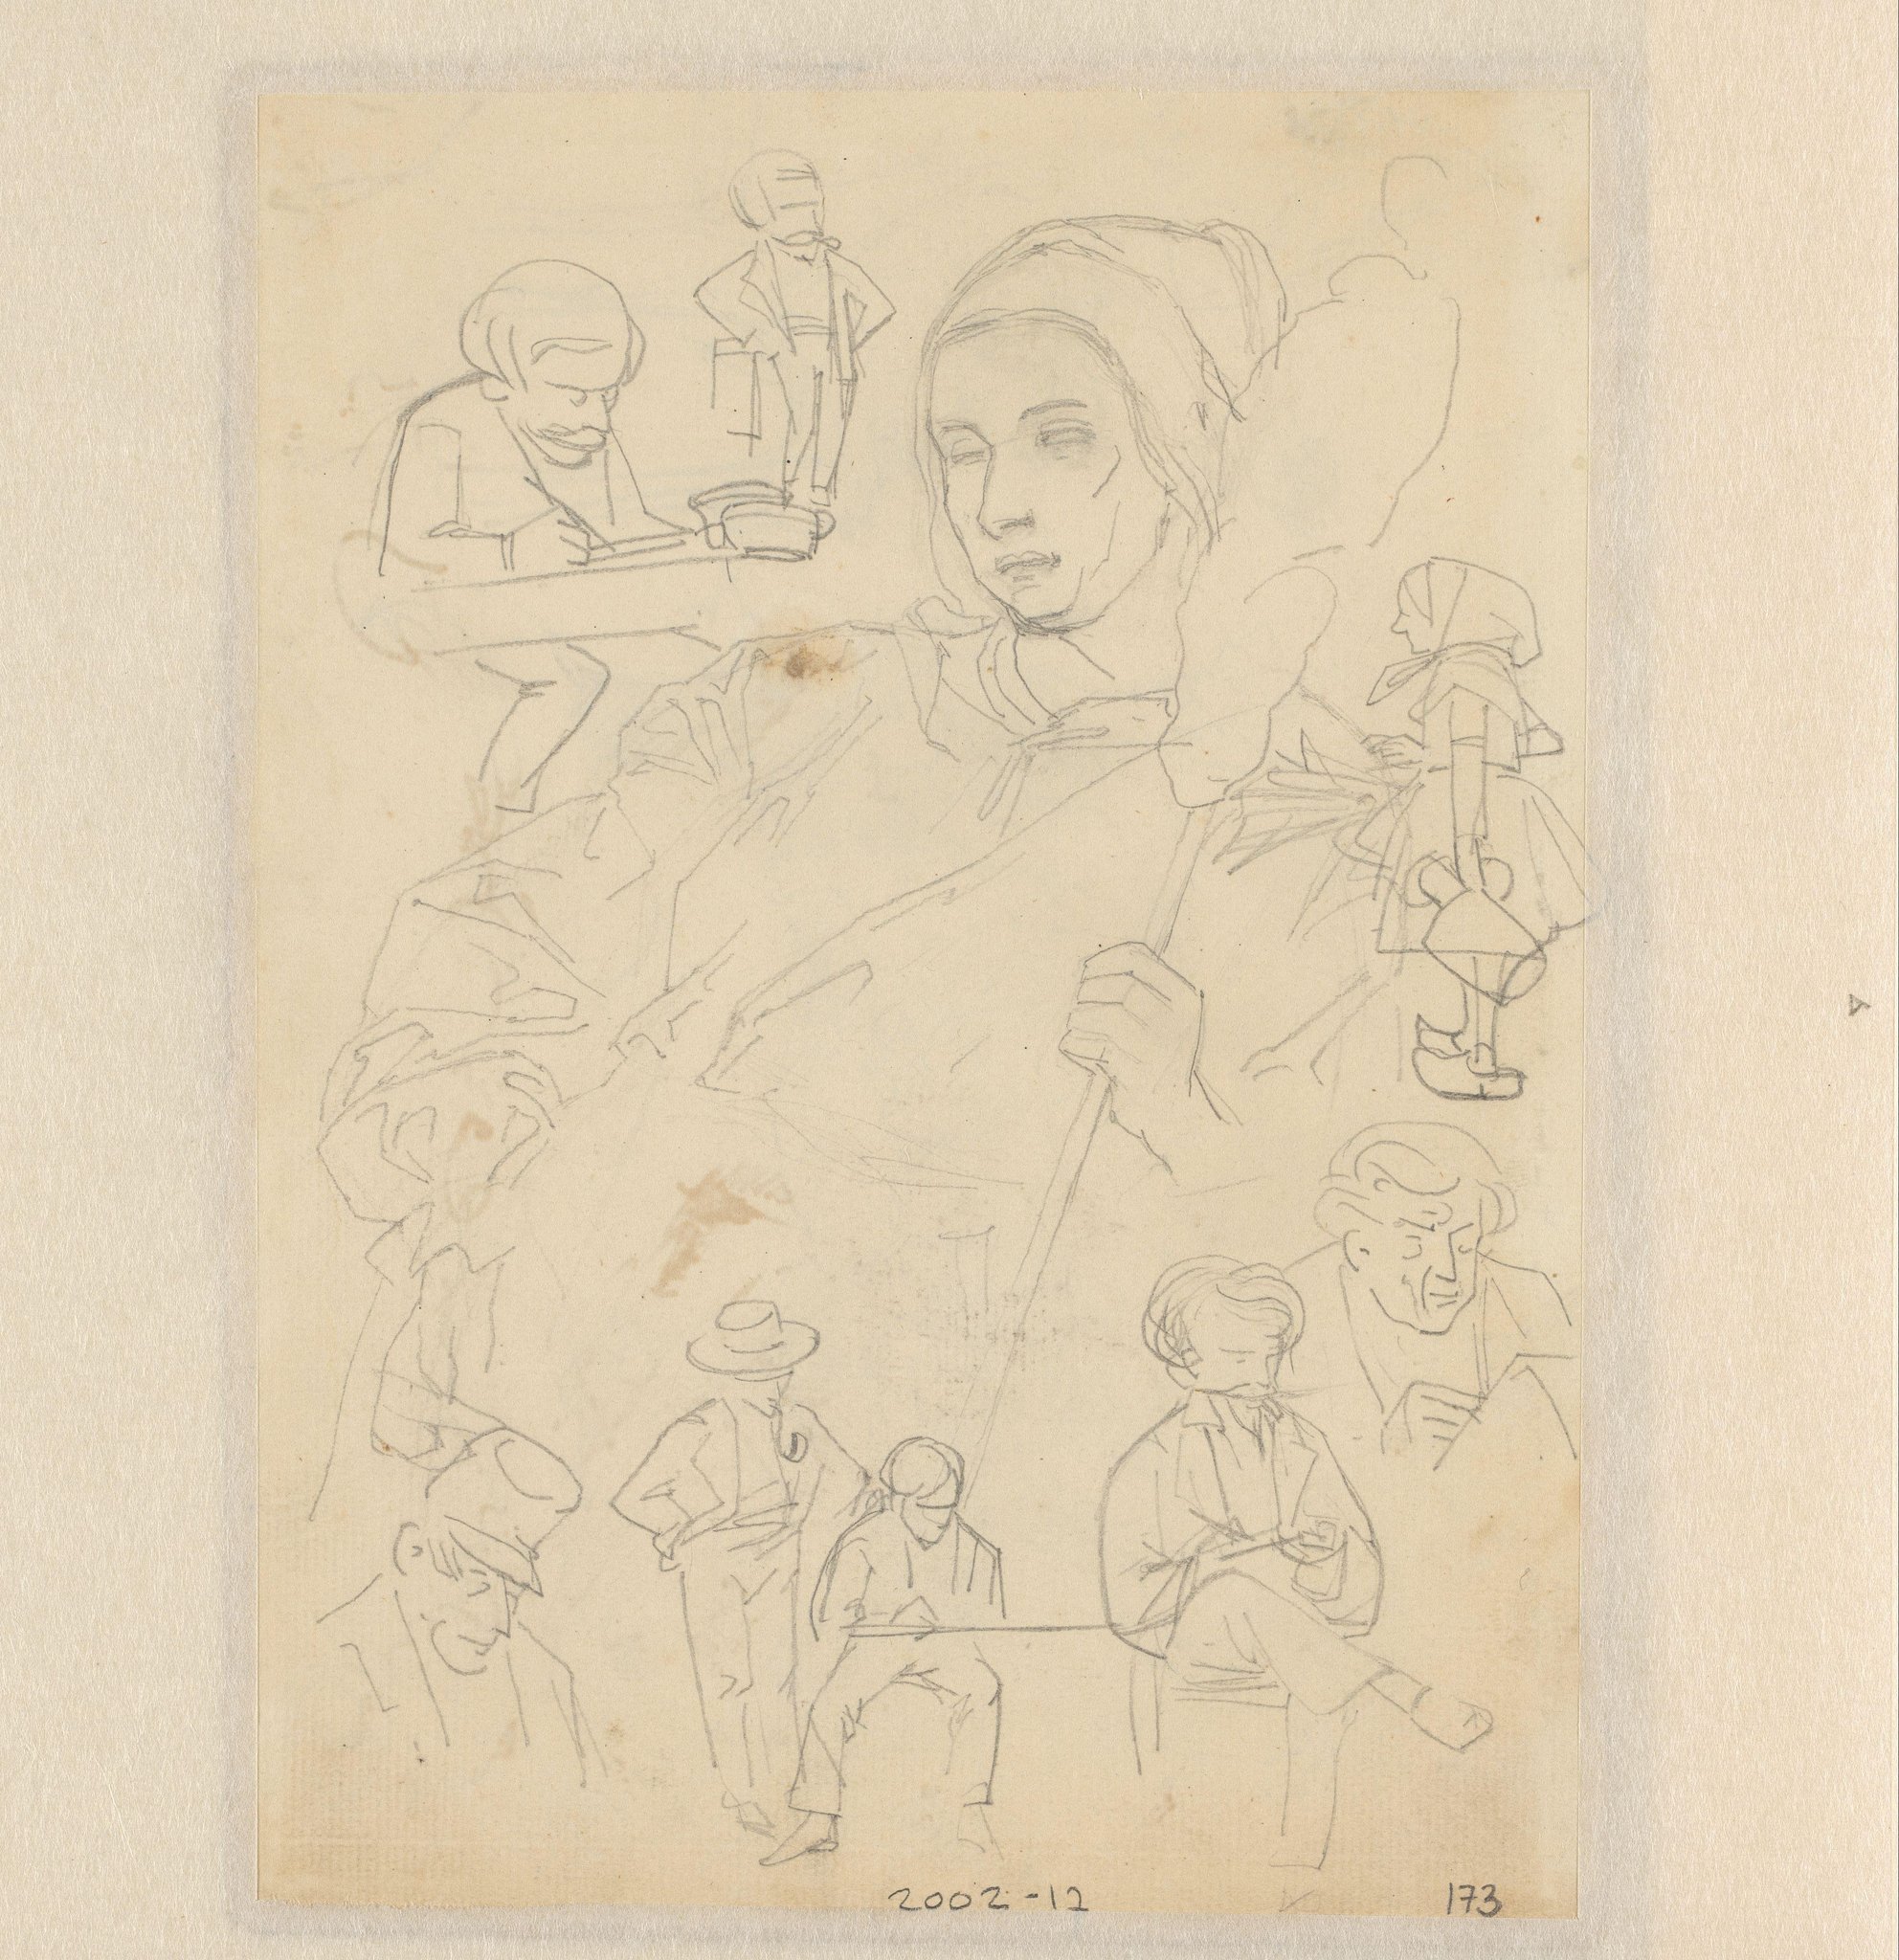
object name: drawing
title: Studies van koppen en figuren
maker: matthijs maris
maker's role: draughtsman, painter, print maker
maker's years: 1839-1917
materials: paper, pencil